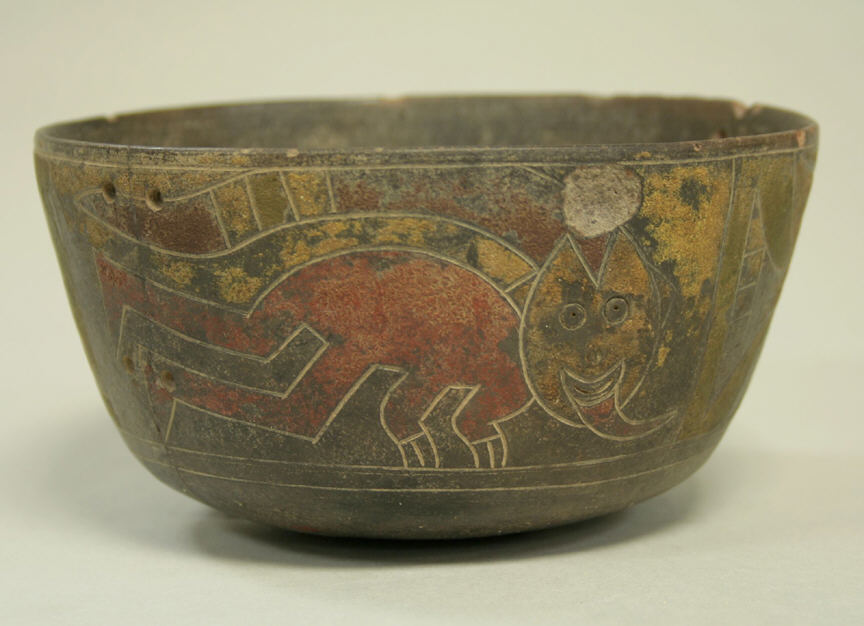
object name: bowl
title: Bowl Incised with Trophy Head Figures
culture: paracas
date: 300-201 BCE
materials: ceramic, pigment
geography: peru